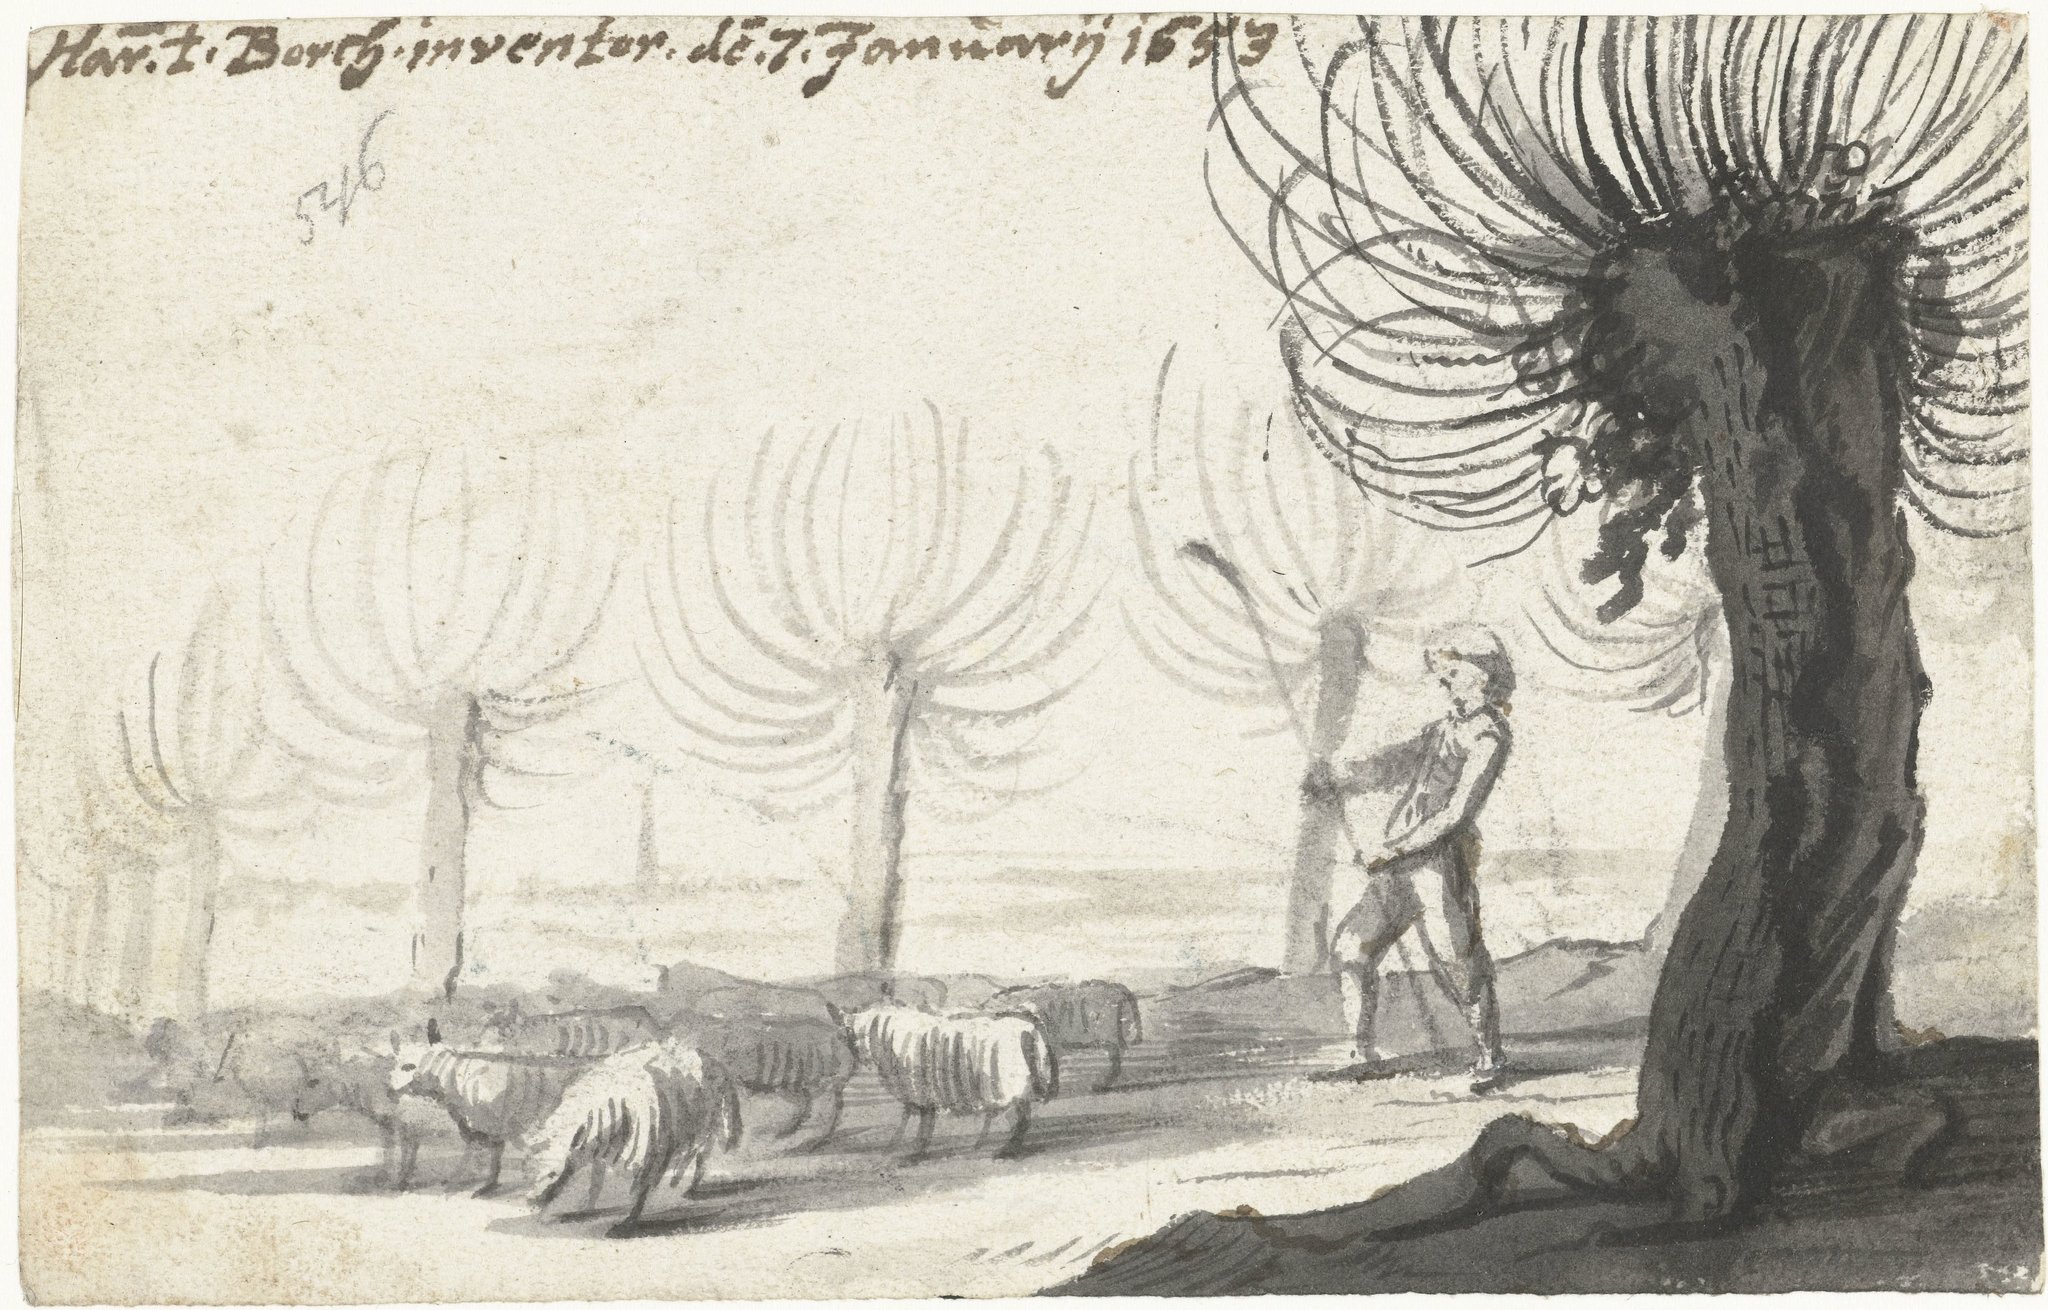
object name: drawing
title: Herder met staf, staand naast schapen en wilgen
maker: harmen ter borch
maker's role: draughtsman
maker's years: 1638-1677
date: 1653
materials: ink, paper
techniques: brush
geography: zwolle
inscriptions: annotation: ‘Har[man].t.Borch. inventor. de[n].7.Januarij 1653’